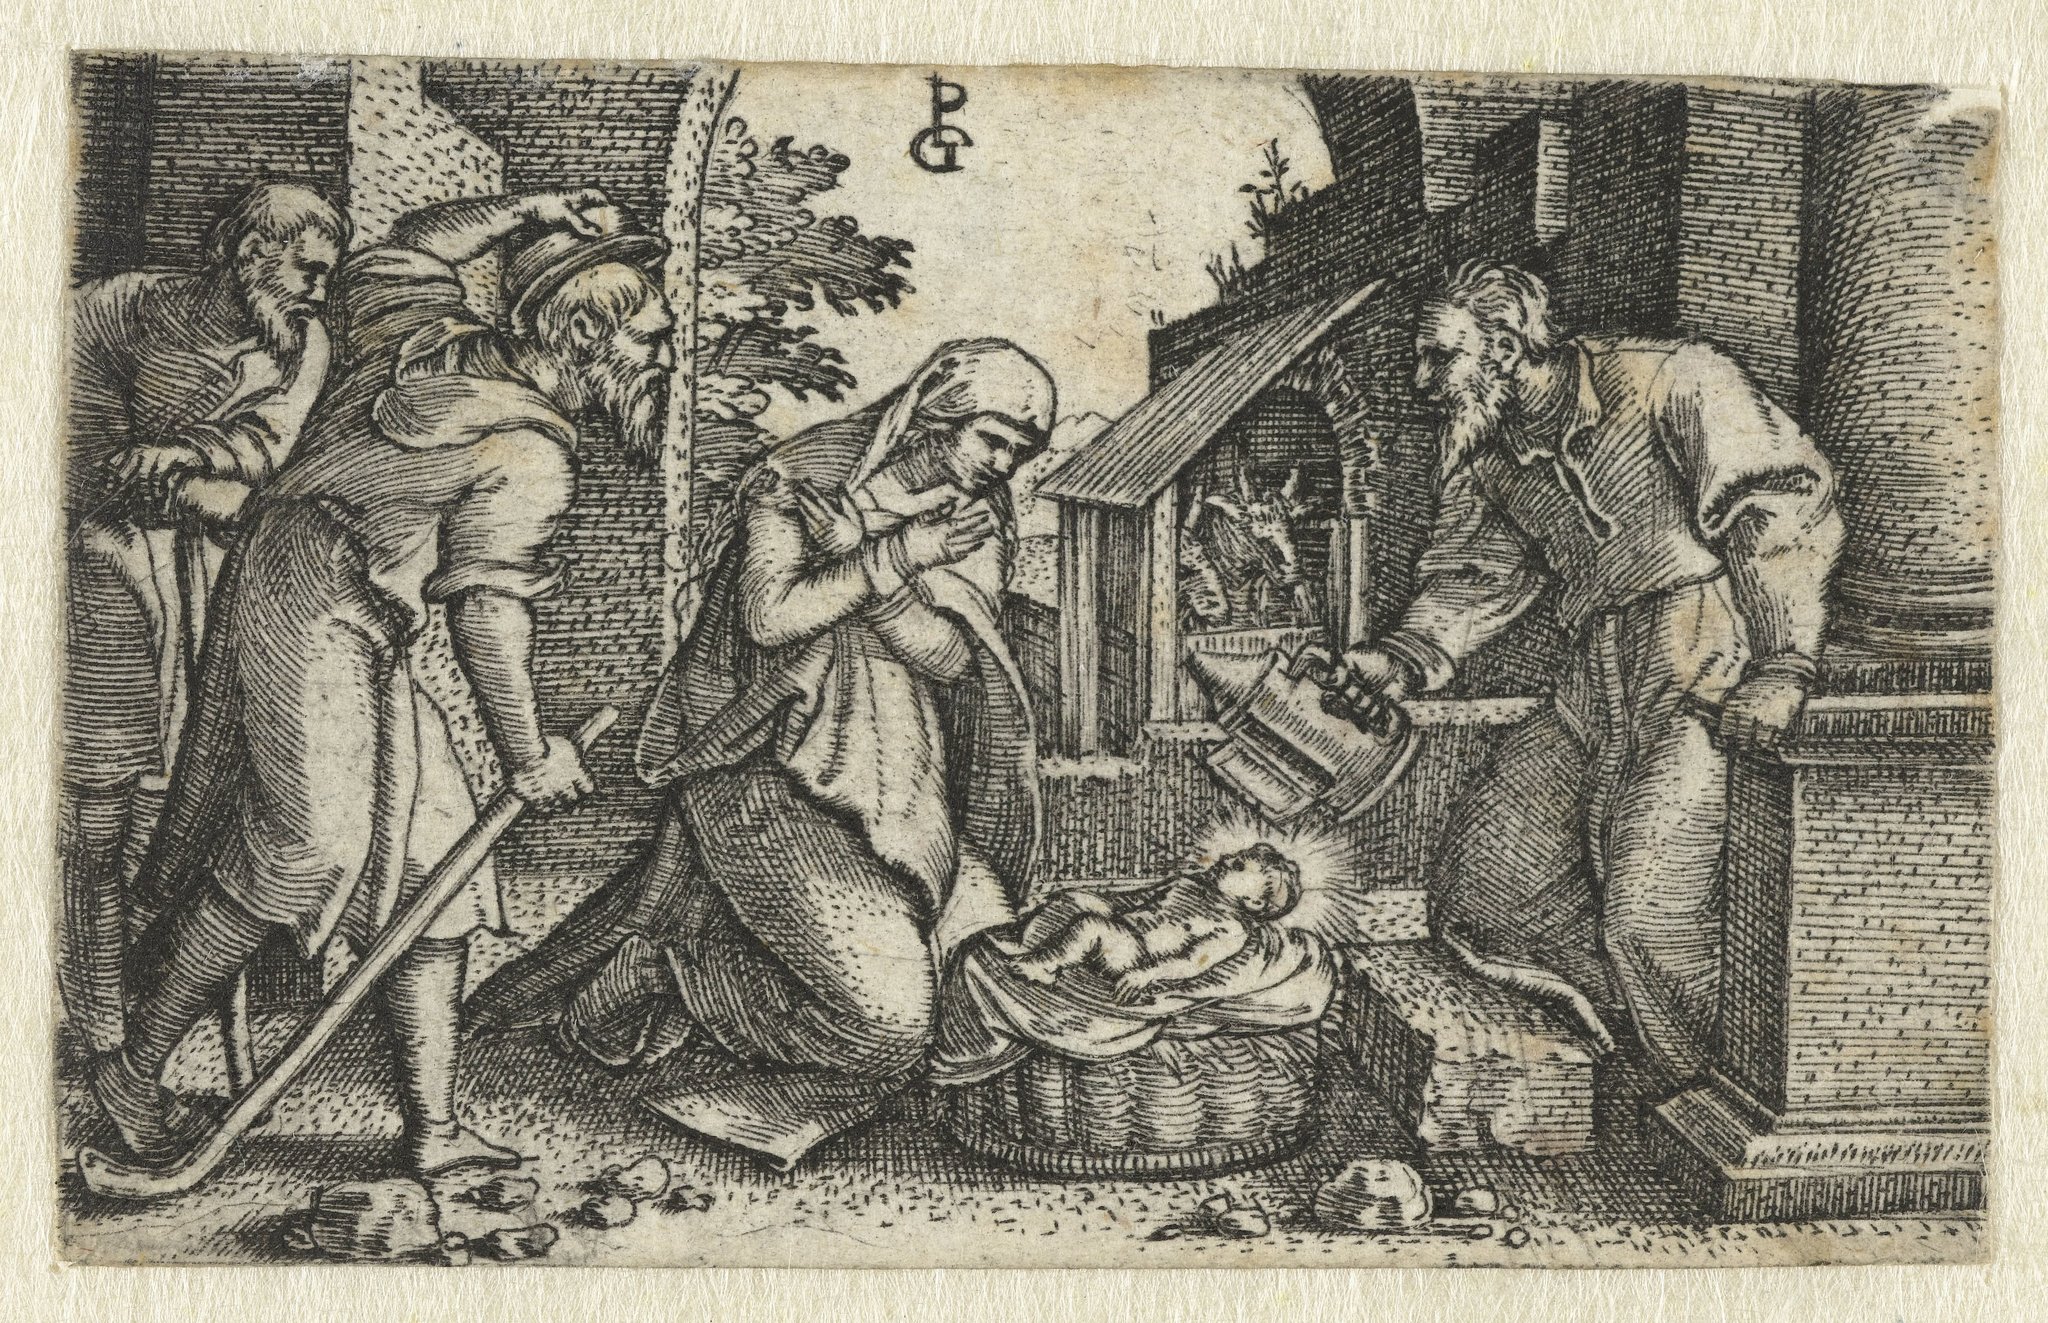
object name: print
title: Leven van Christus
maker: georg pencz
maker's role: draughtsman, painter, print maker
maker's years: 1500-1550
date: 1534-1535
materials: paper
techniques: engraving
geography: germany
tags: adoration of the christ-child by the shepherds; mary and joseph present, mary, joseph and the new-born christ (nativity)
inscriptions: collector's mark: Lugt 240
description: Eerste prent uit een serie van zesentwintig prenten met als thema het leven van Christus.